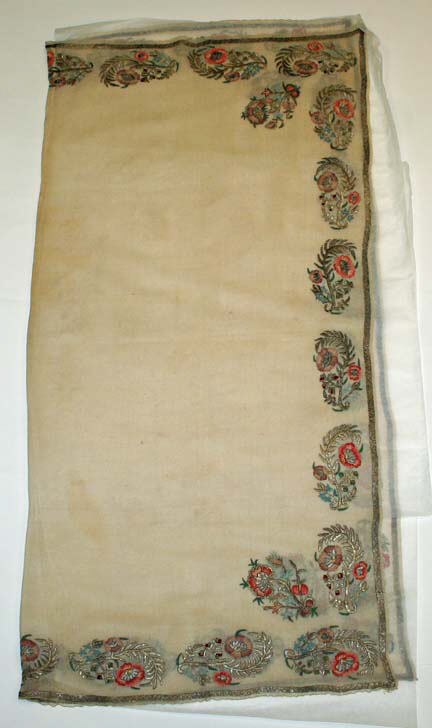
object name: veil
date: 1701-1900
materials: metal thread, silk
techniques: embroidery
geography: middle east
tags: flowers